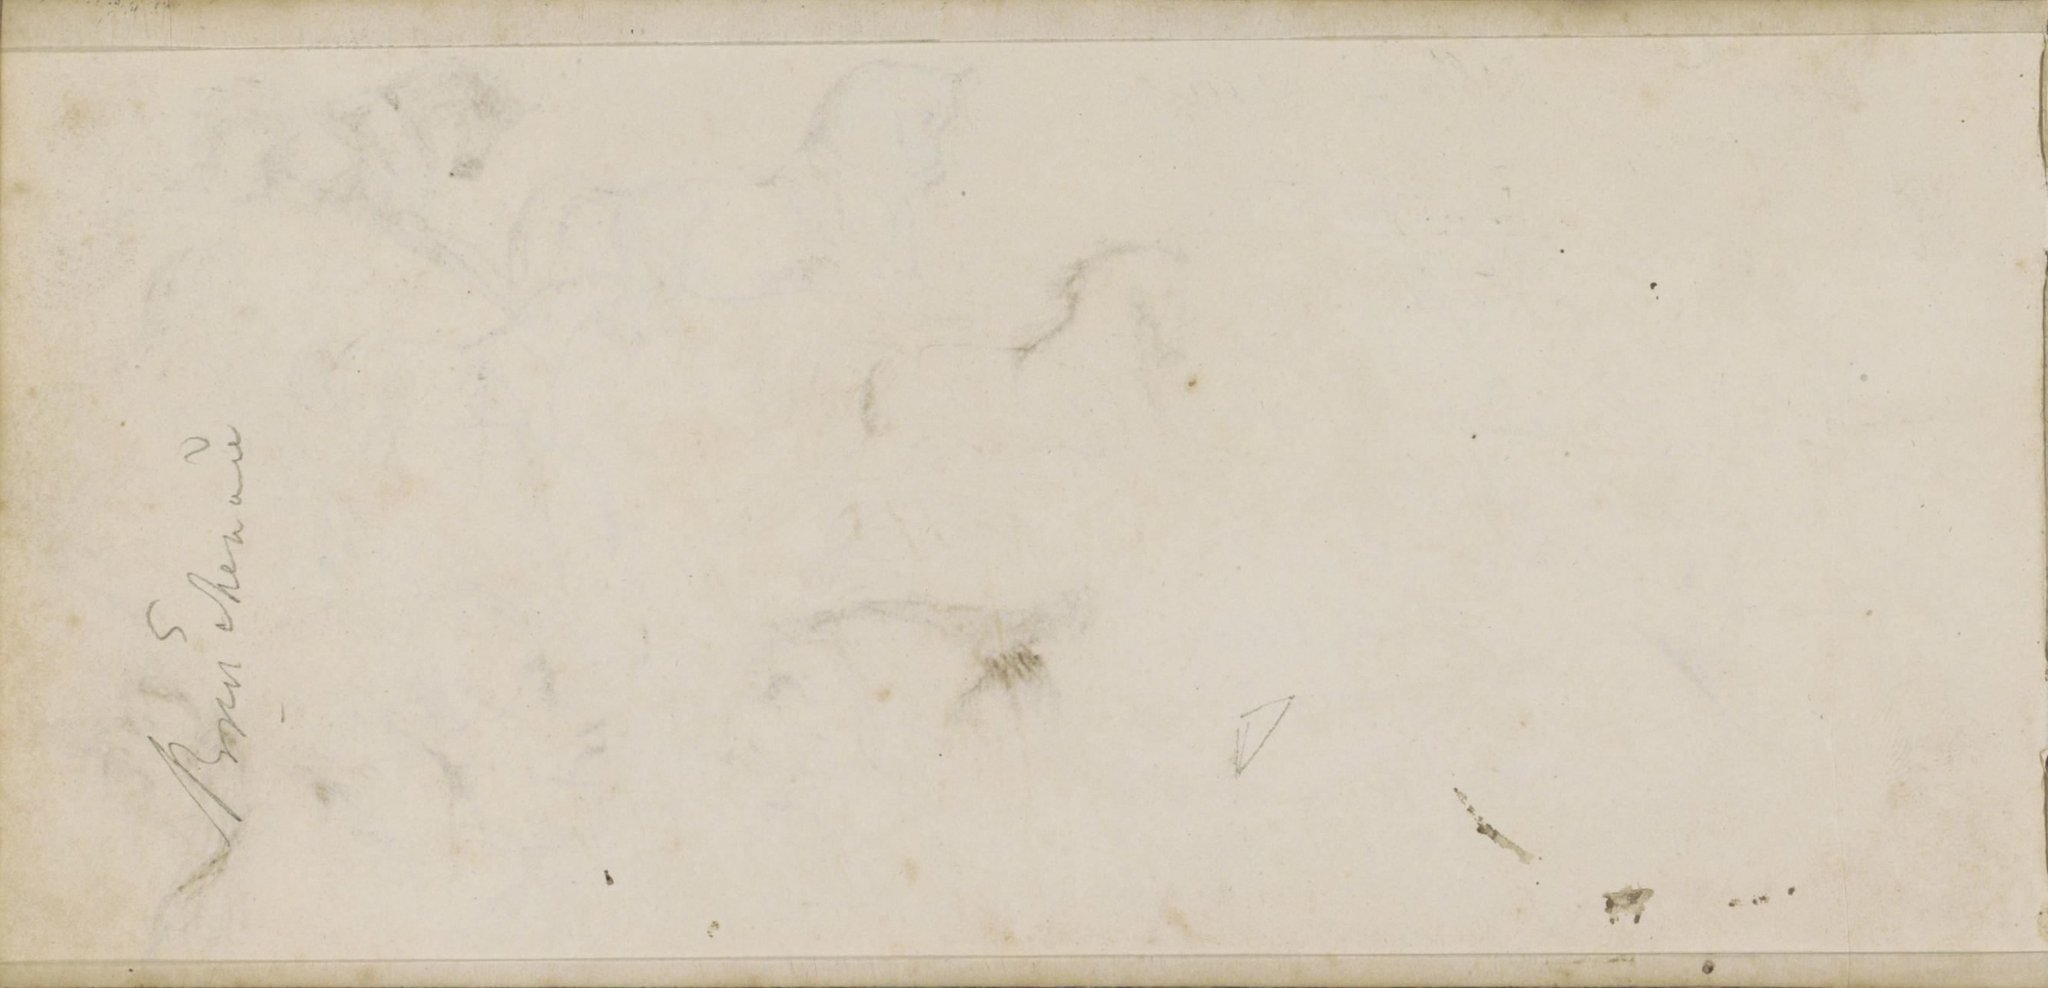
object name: sketchbook leaf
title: Annotatie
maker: johannes tavenraat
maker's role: draughtsman, painter, print maker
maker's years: 1809-1881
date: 1840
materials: paper, pencil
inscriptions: annotation: ‘B[...]n Shenau[...]’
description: Blad 1 verso uit een schetsboek met 63 bladen.